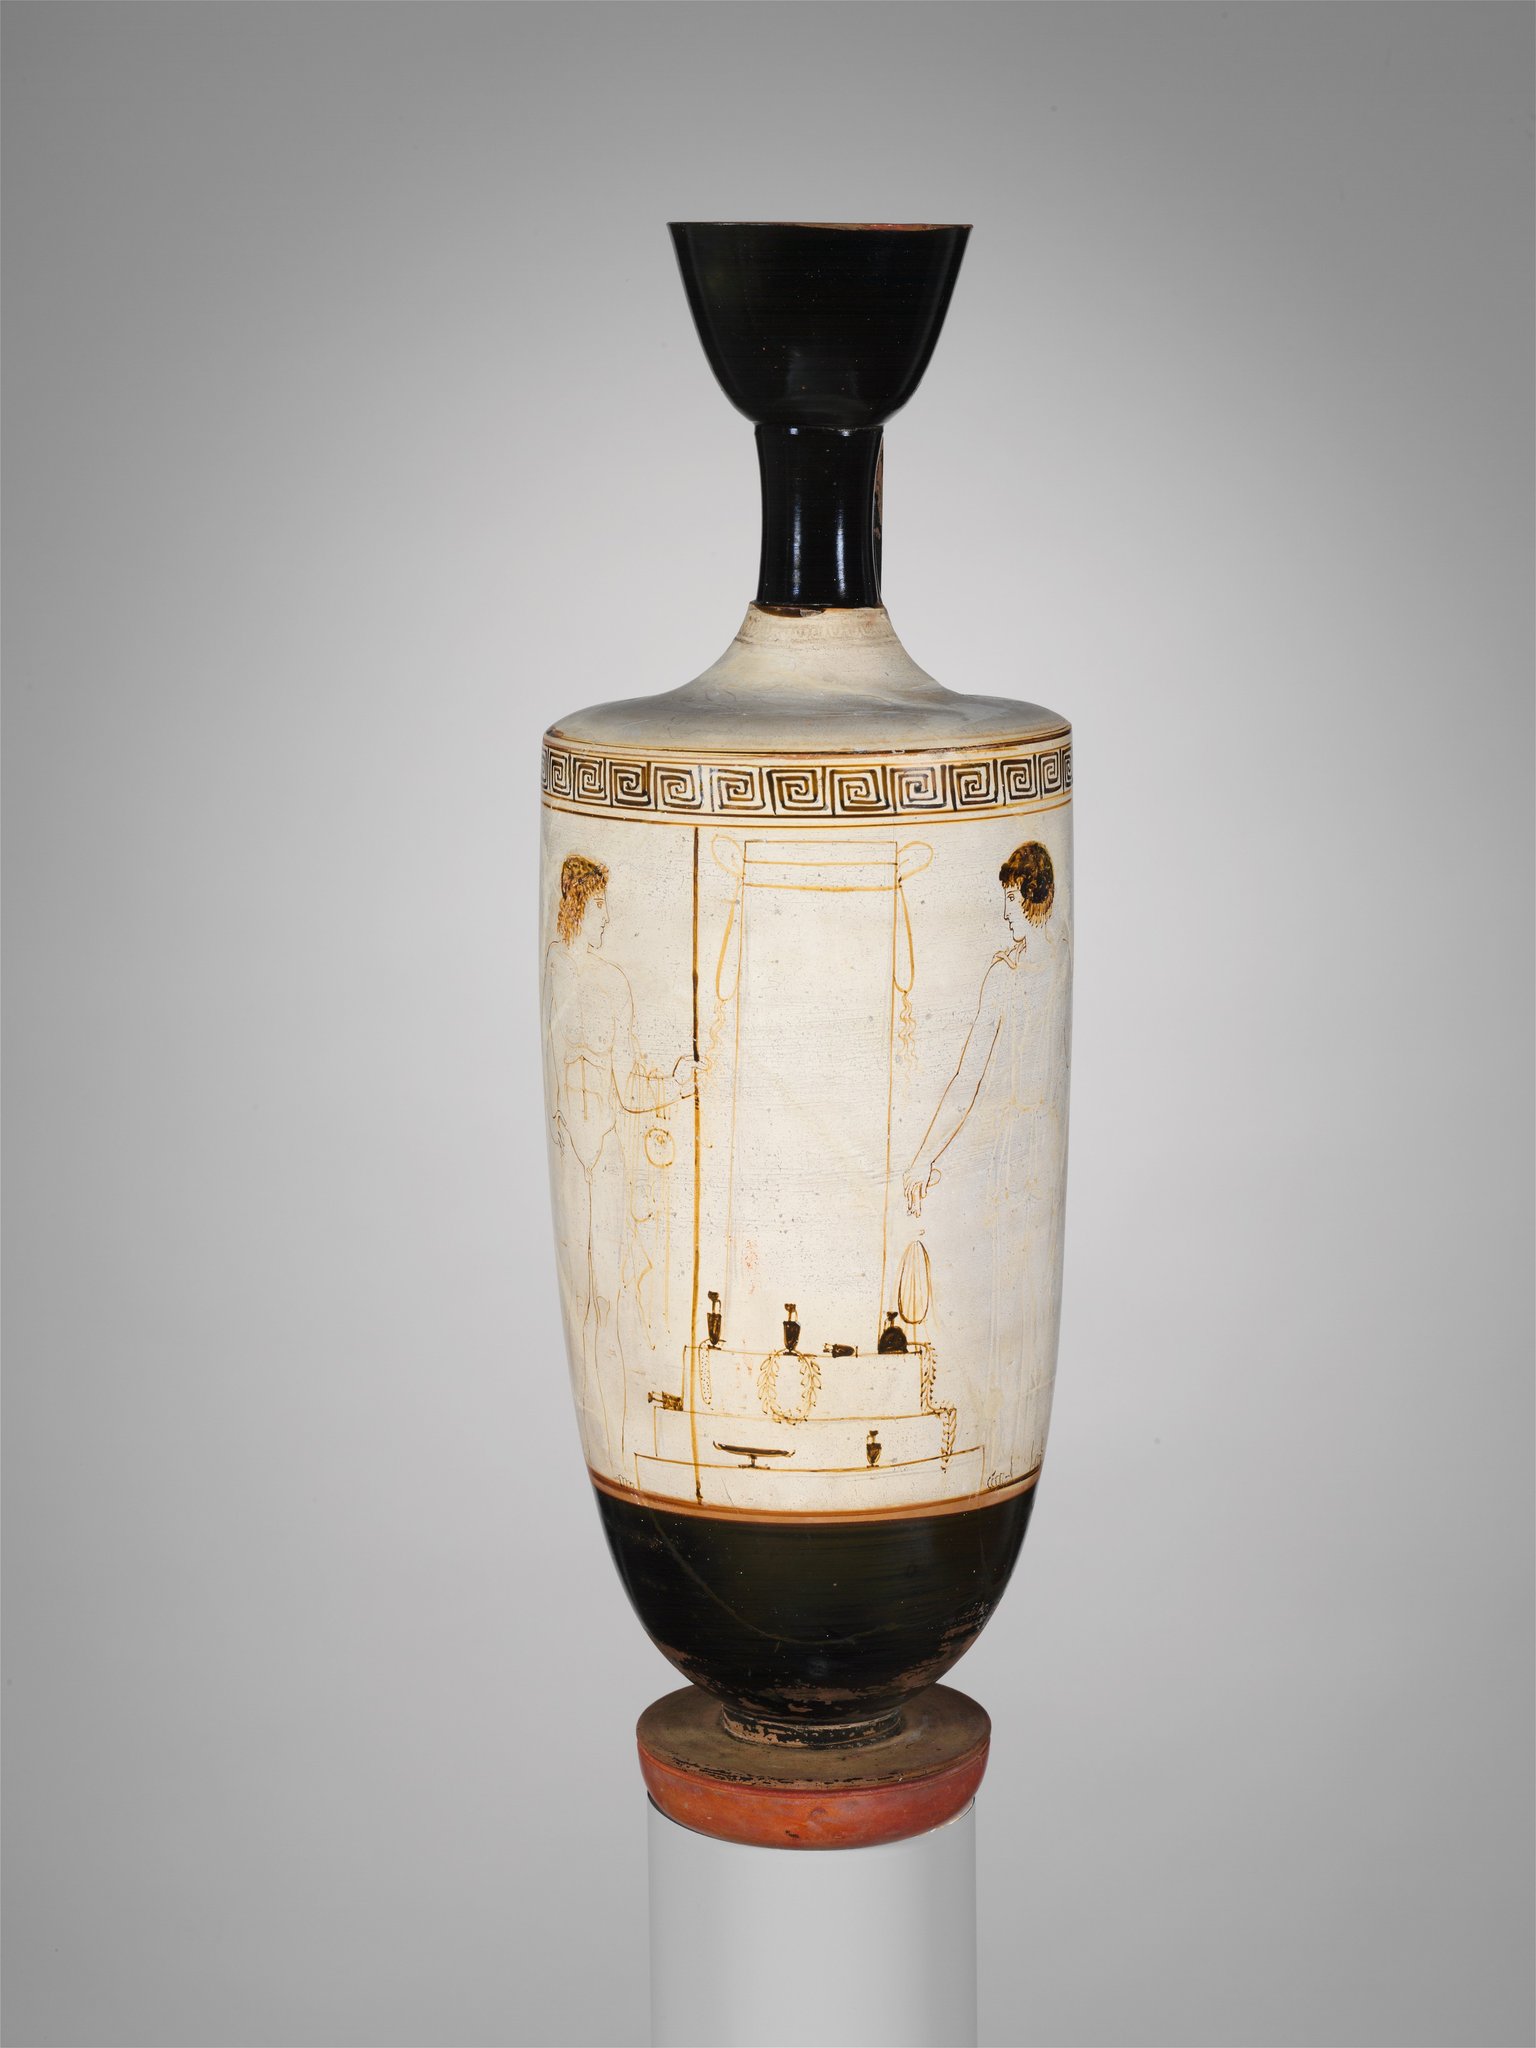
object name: lekythos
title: Terracotta lekythos (oil flask)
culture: greek, attic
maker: bosanquet painter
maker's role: artist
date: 440-430 BCE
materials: terracotta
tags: tombs,male nudes,women